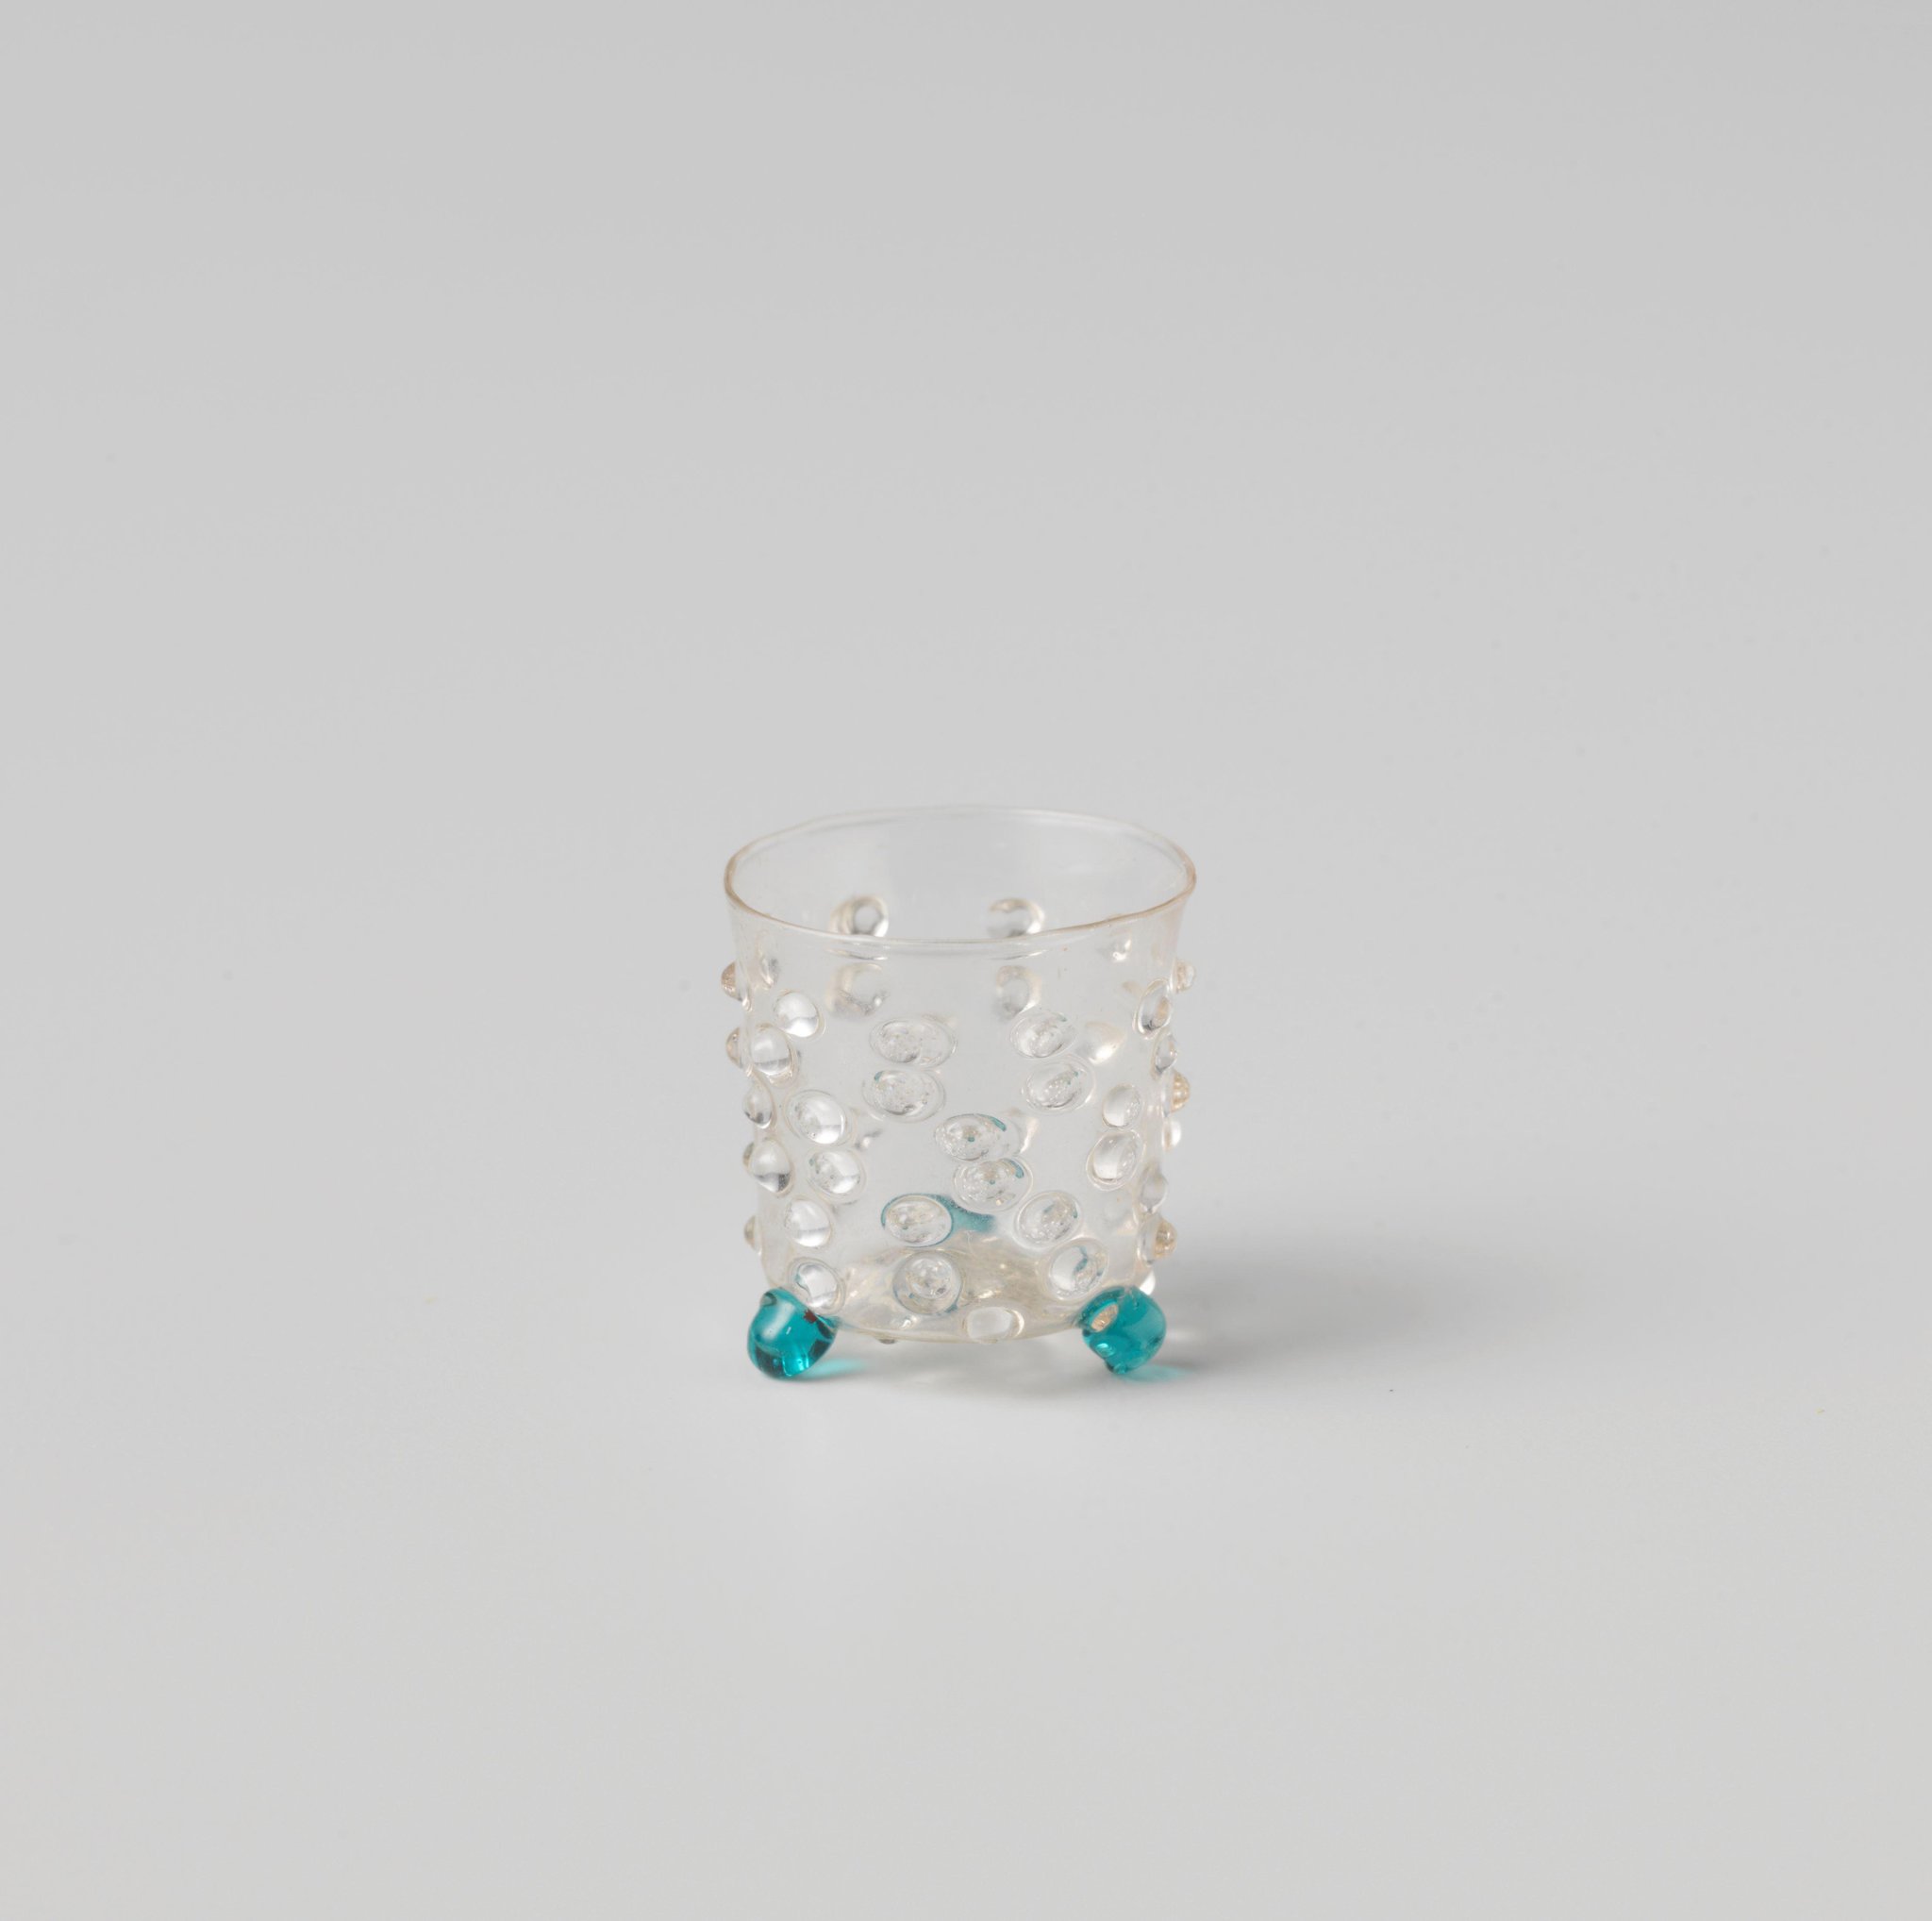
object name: miniature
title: Beker versierd met wratten en noppen, op drie bolpoten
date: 1675-1699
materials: glass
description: Beker van helder kleurloos glas versierd met wratten en noppen, staand op drie blauwe bolpoten.